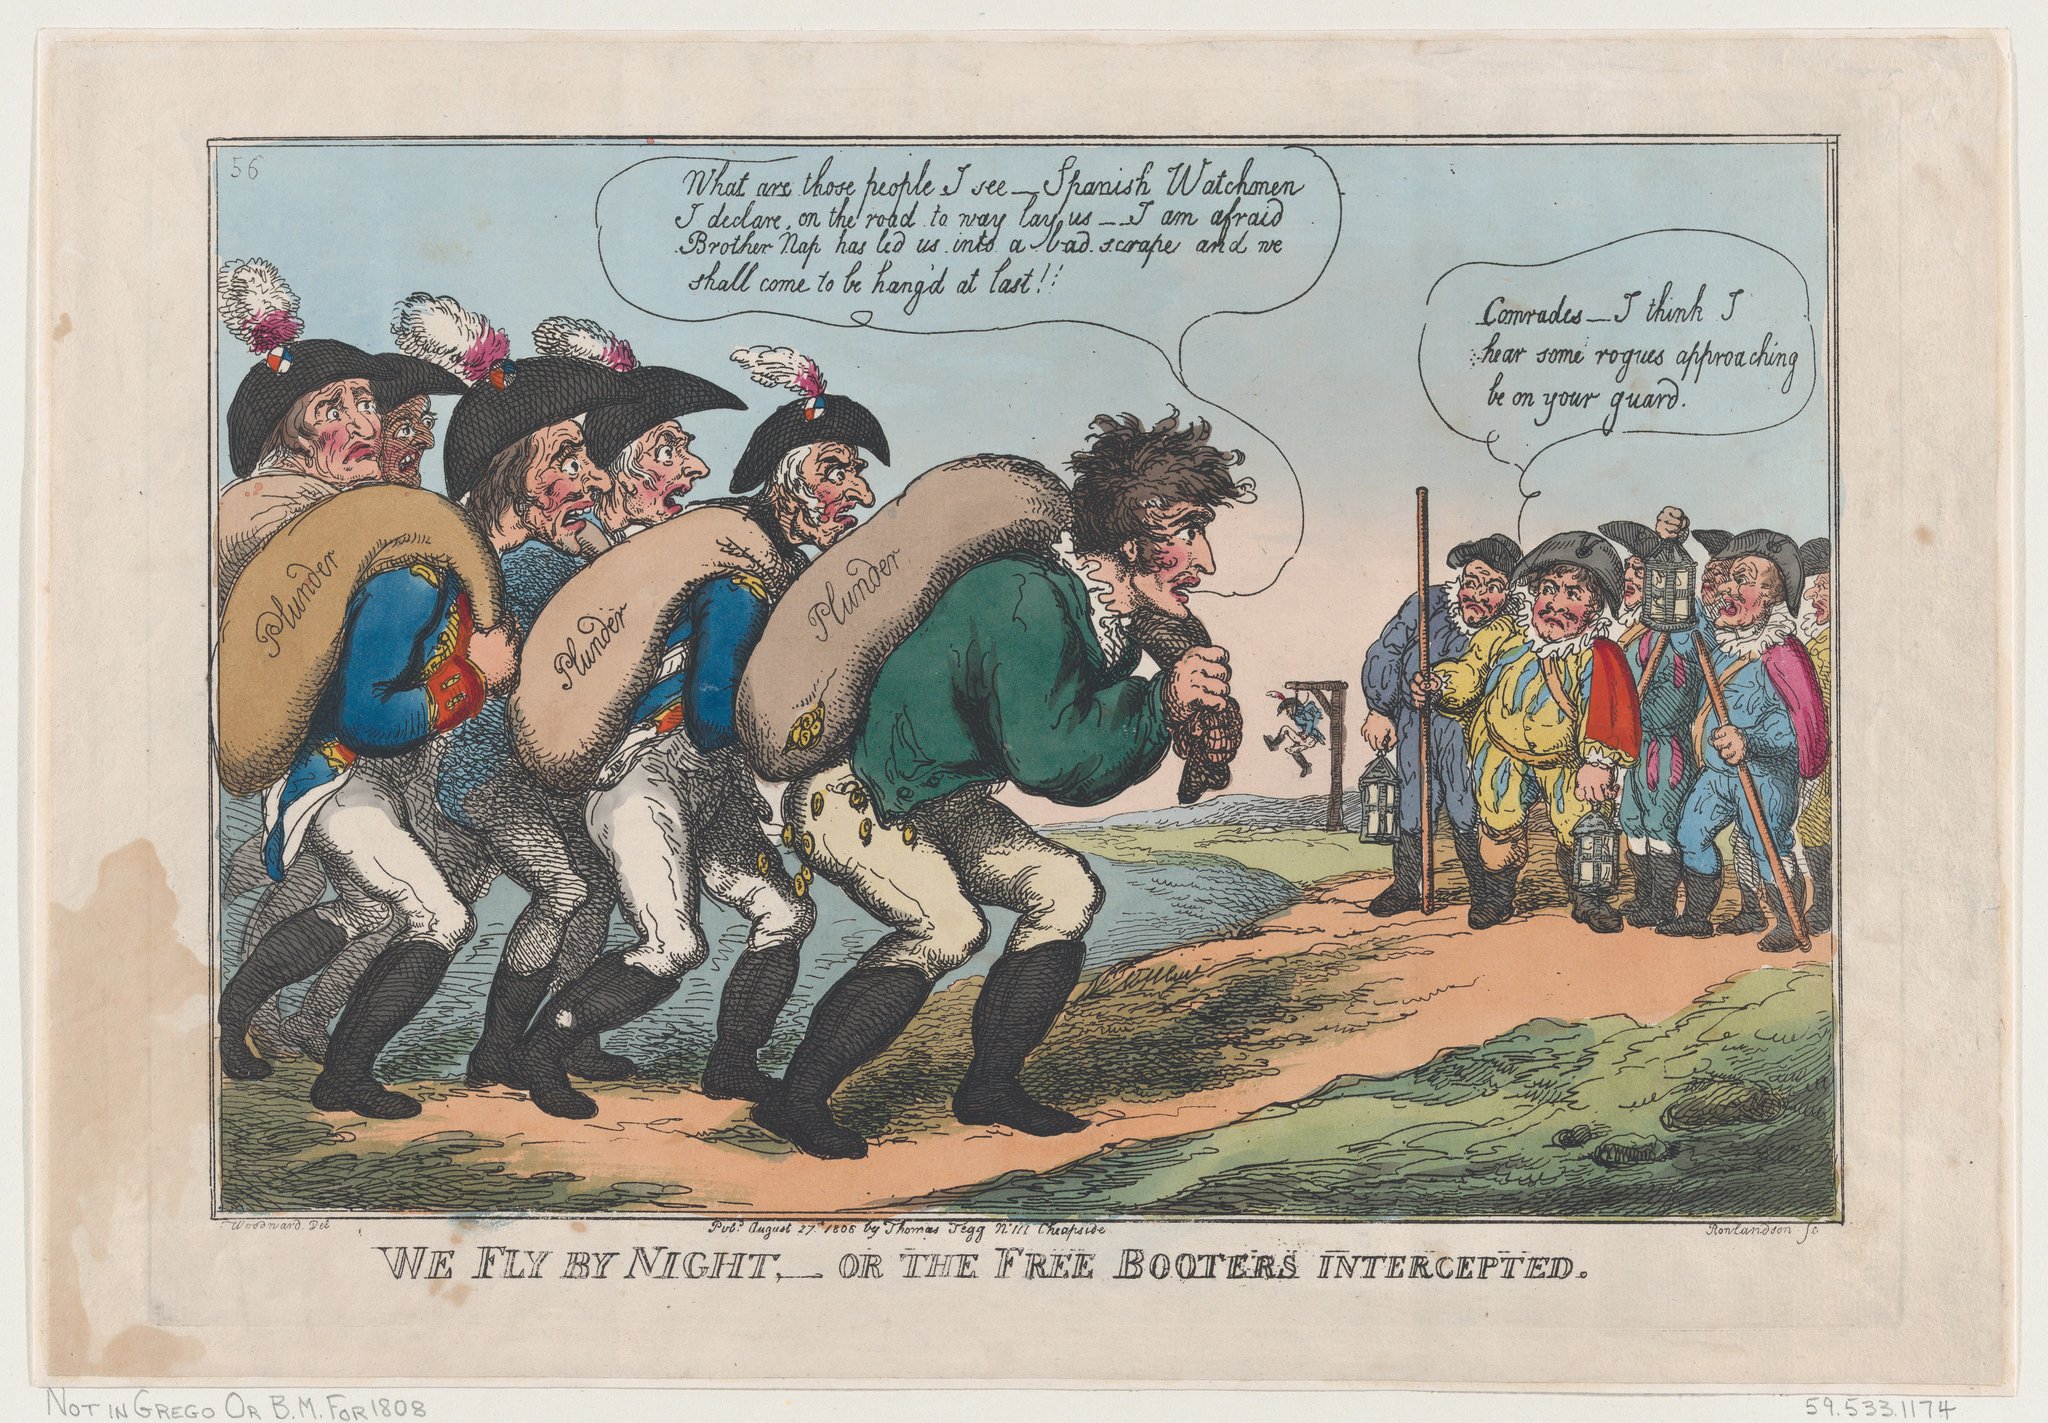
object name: print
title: We Fly By Night, Or The Free Booters Intercepted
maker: thomas rowlandson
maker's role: artist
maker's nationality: british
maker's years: 1757-1827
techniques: etching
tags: satire,men,politics